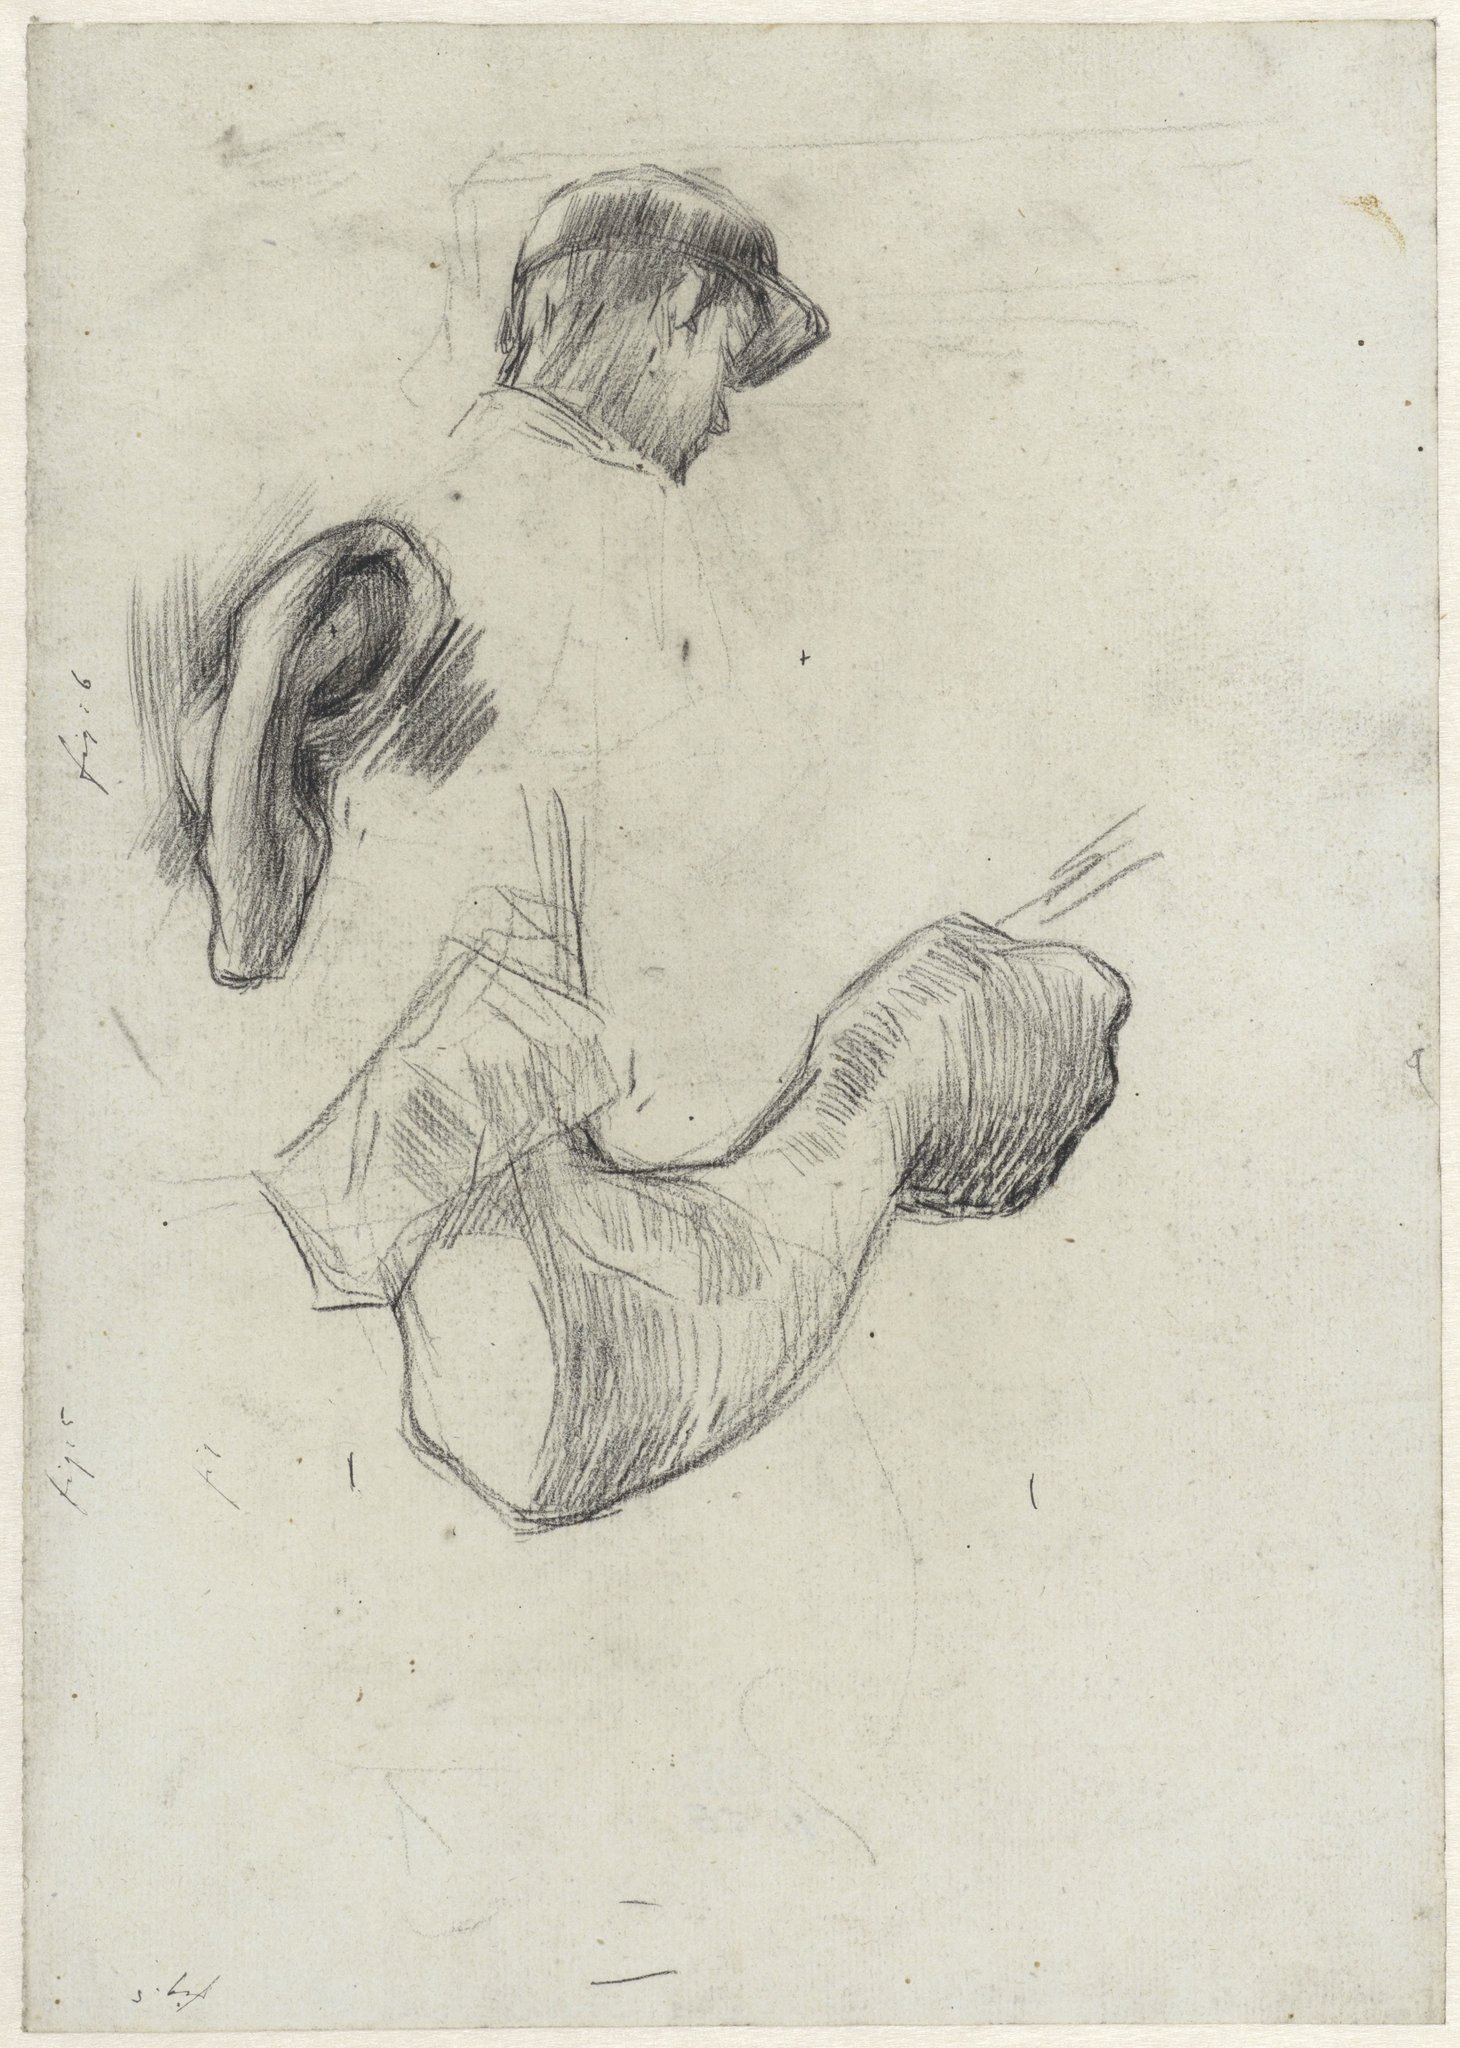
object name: drawing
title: Studieblad met schetsen van een arbeider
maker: anthon gerhard alexander van rappard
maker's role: draughtsman, print maker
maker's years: 1858-1892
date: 1868-1892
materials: charcoal, paper